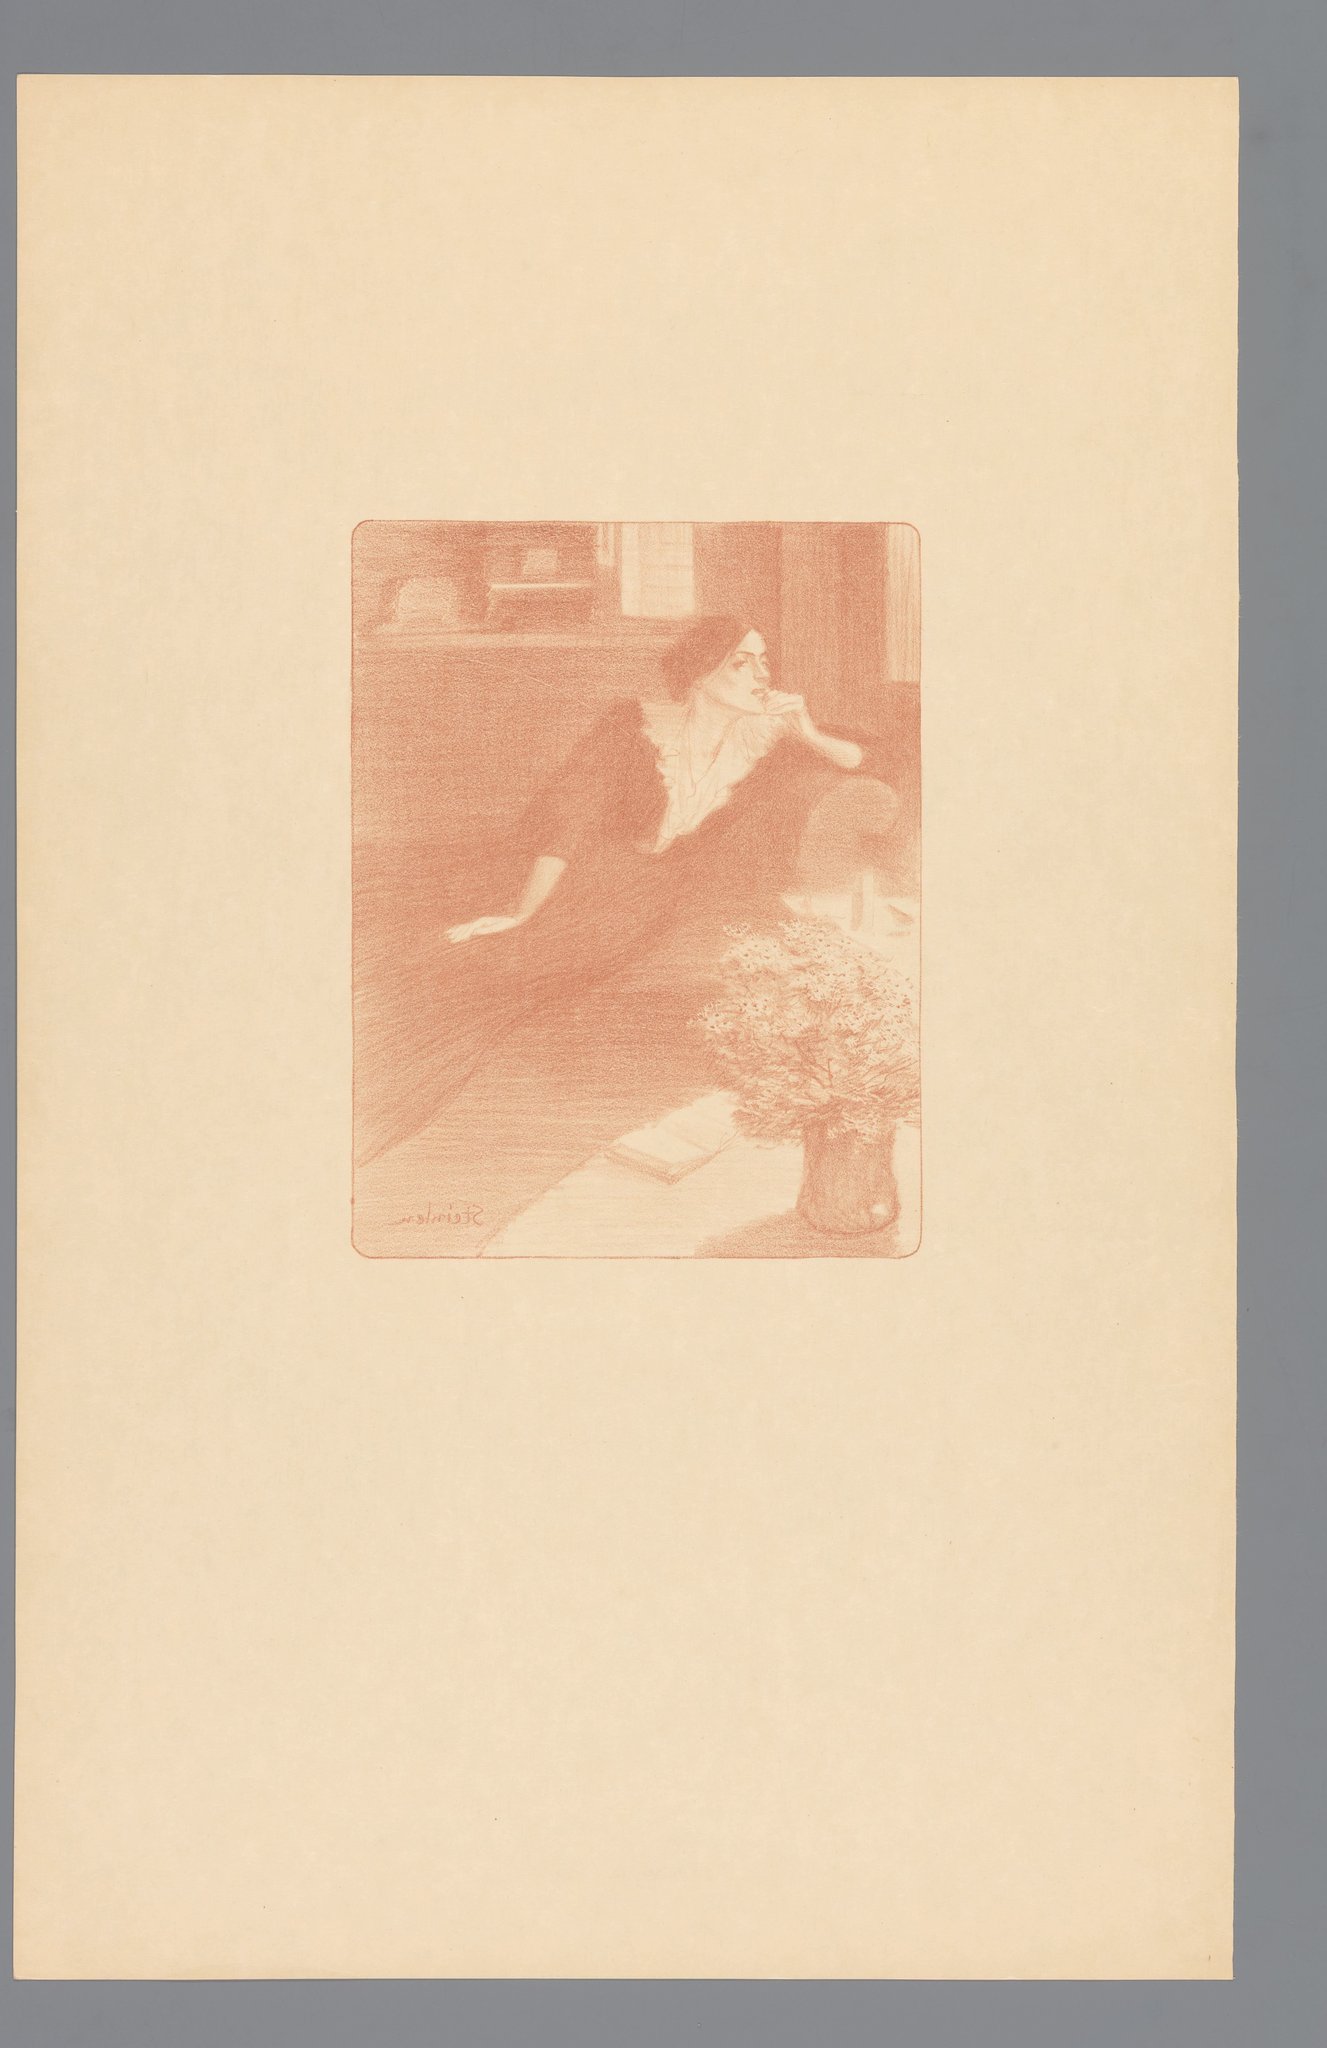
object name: print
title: Chanson Crépusculaire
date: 1897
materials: paper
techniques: lithograph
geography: paris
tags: grand piano, bunch of flowers ~ ornament, female sex; woman, couch, sofa, settee, neck-gear: collar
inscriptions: collector's mark: Lugt 2760, collector's mark: Lugt 2228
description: Rechts op de voorgrond een tafel waarop een open boek en een vaas met bloemen. Bij de tafel zit een dame in een donkere japon met grote witte kraag, op een chaise longue, de linkerarm steunend op de leuning, voor zich uit te staren. Achter haar een gedeelte van een kast; rechts een venster. Linksonder gesigneerd (de naam Steinlen in spiegelbeeld) No.13 uit 'Chansons de Femmes' van Paul Delmet.